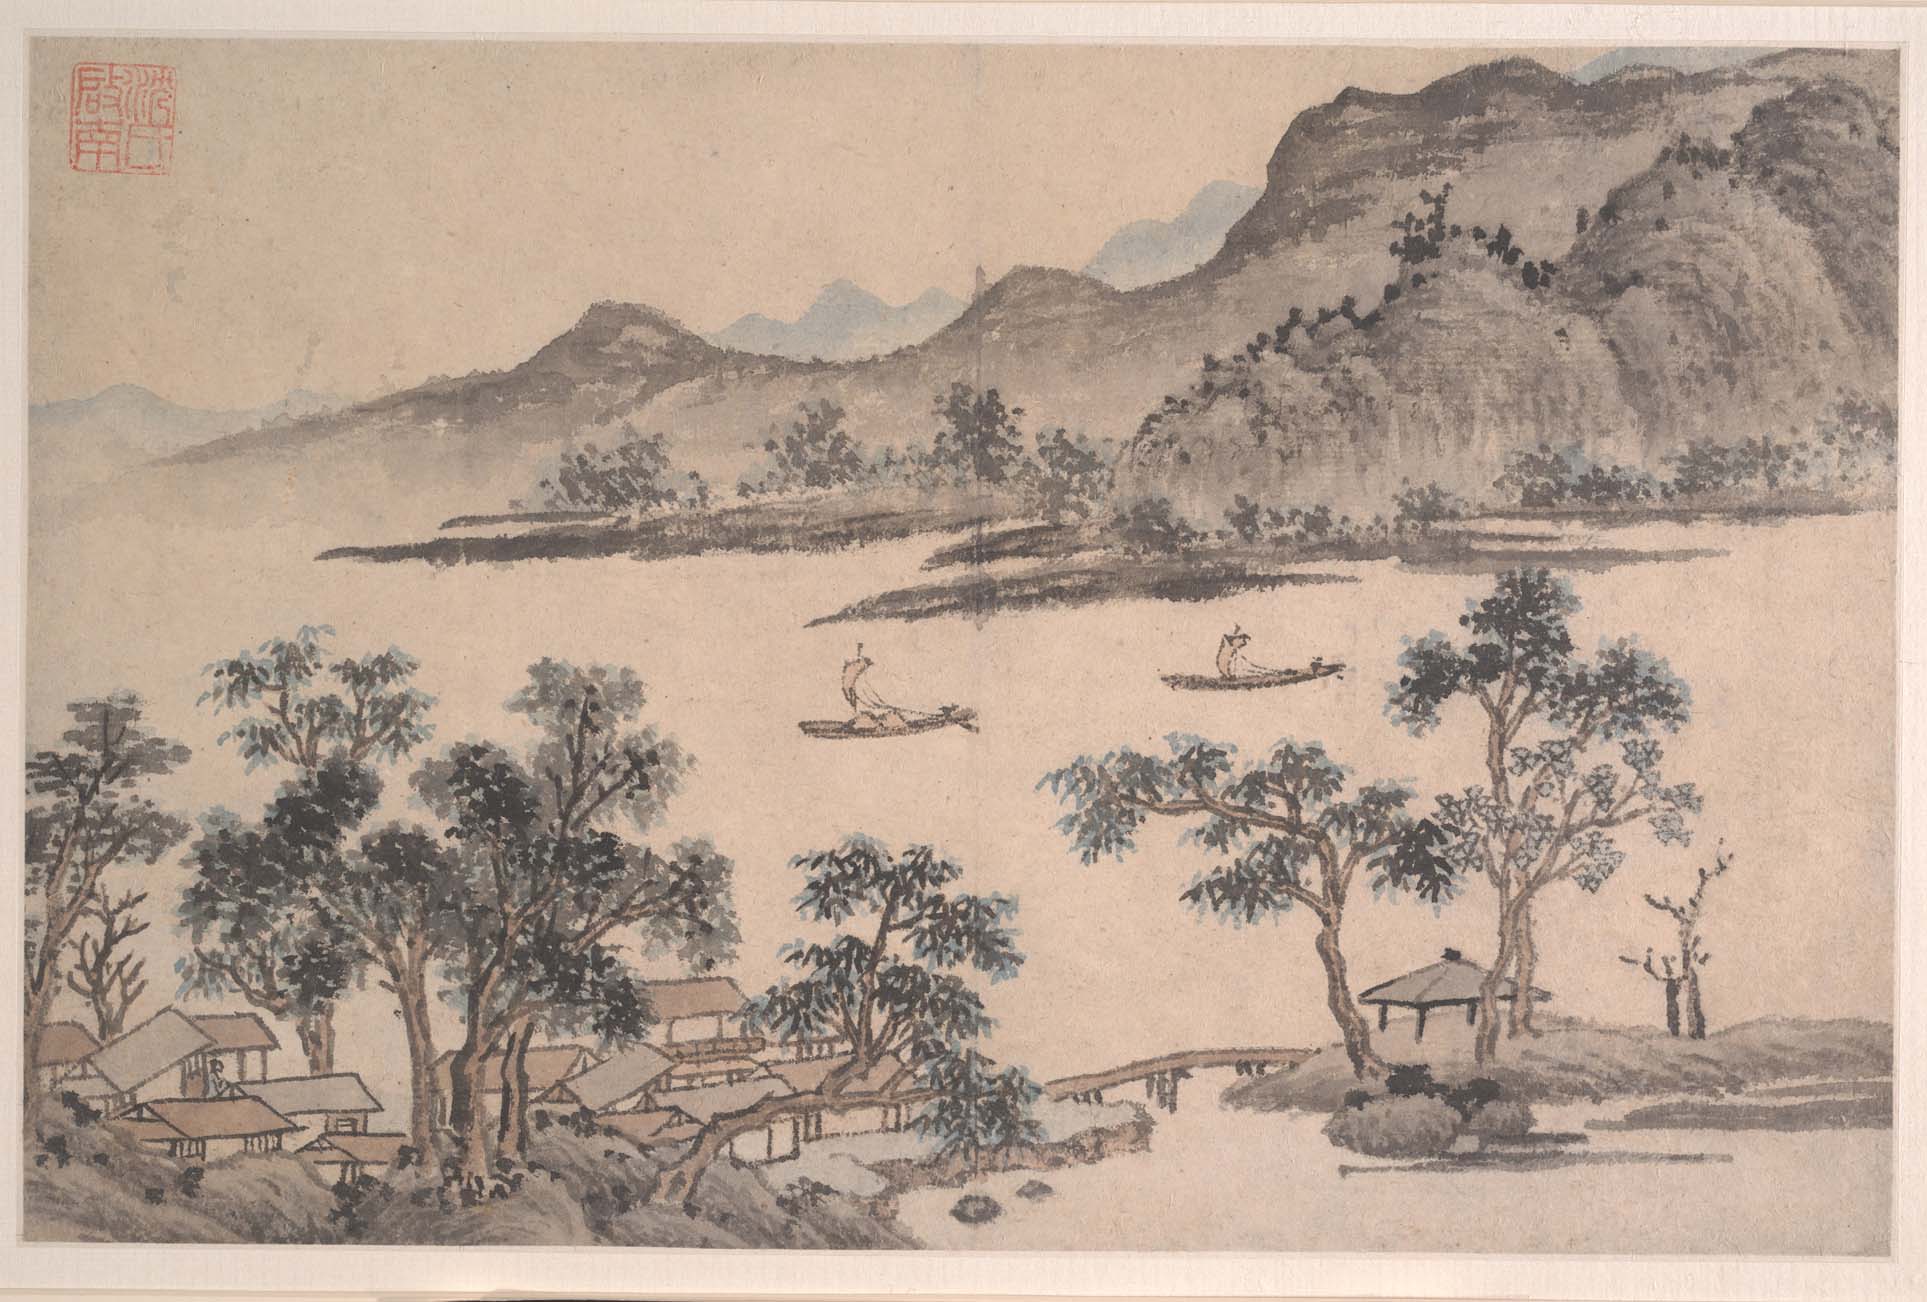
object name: album leaf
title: Landscape with Sailboats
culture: chinese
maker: shen zhou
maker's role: artist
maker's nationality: chinese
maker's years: 1427-1509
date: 1427-1509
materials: ink, paper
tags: mountains,landscapes,boats